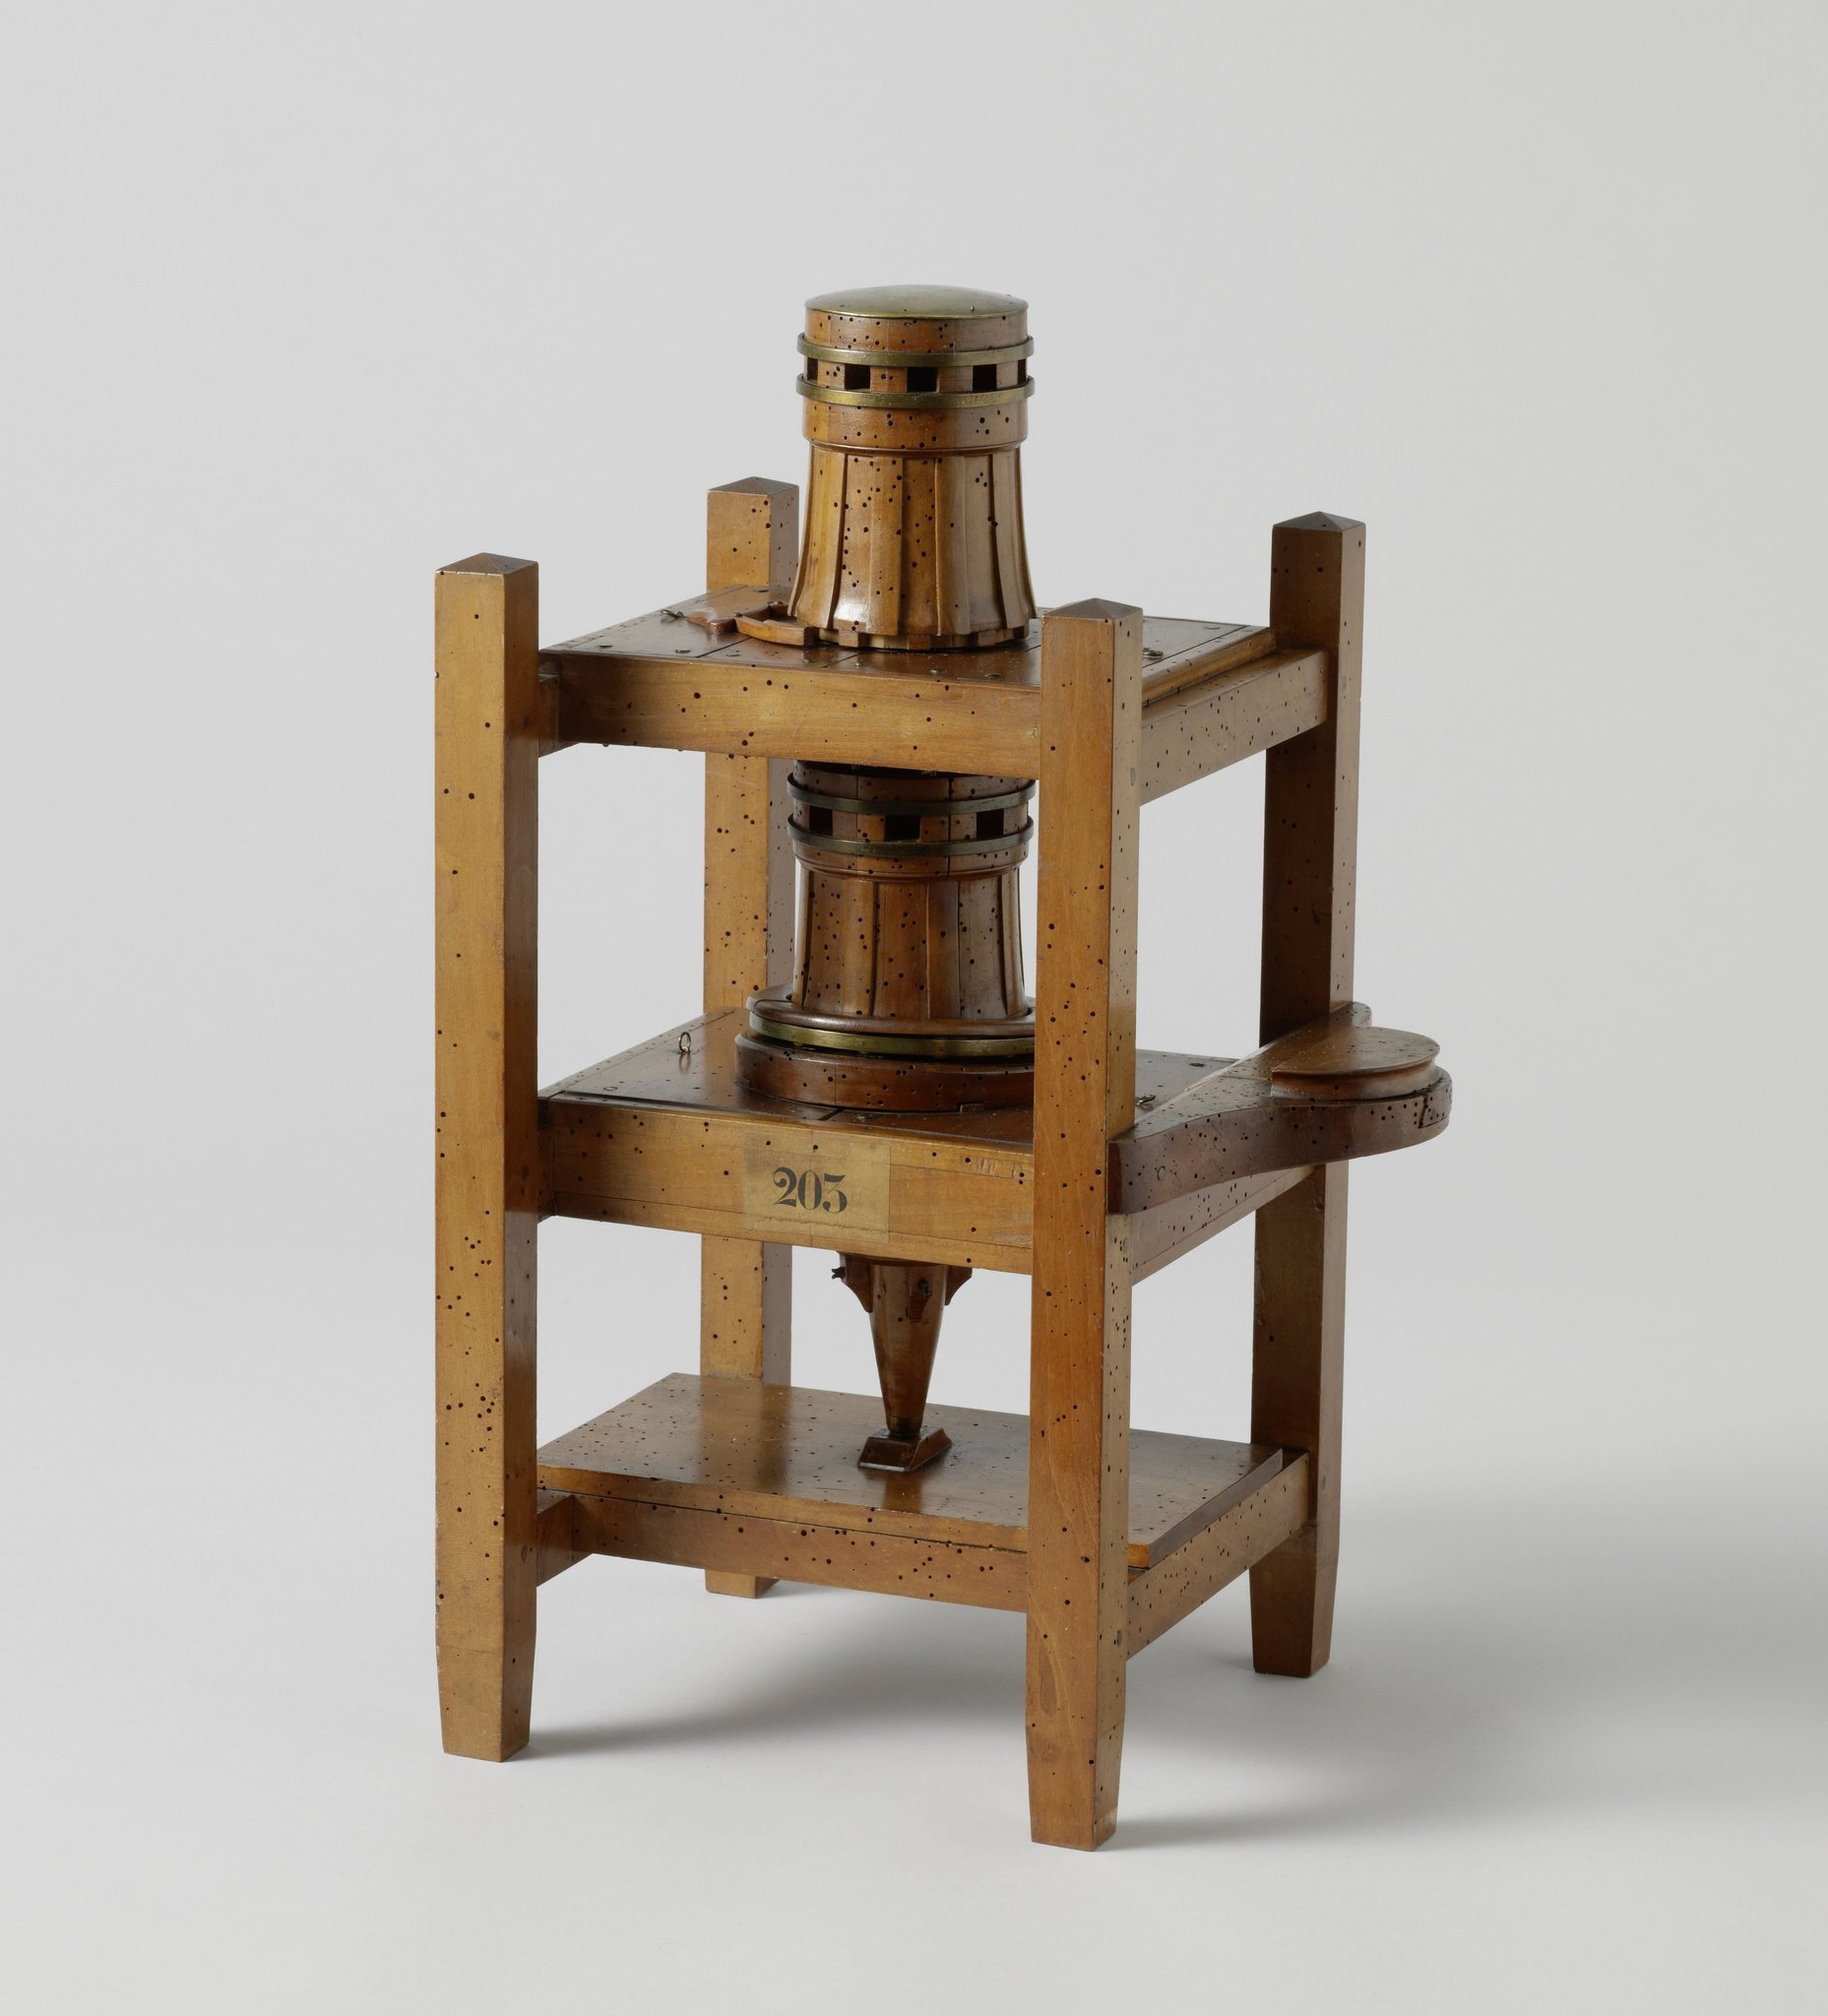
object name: demonstration model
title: Model of a Double Capstan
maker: Anonymous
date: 1800-1850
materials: brass, wood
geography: netherlands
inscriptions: label, on the frame: ‘203’ former inventory label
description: Deze kaapstander is geïnspireerd op het ontwerp van Forfait, met een iets anders ingericht hellend vlak.